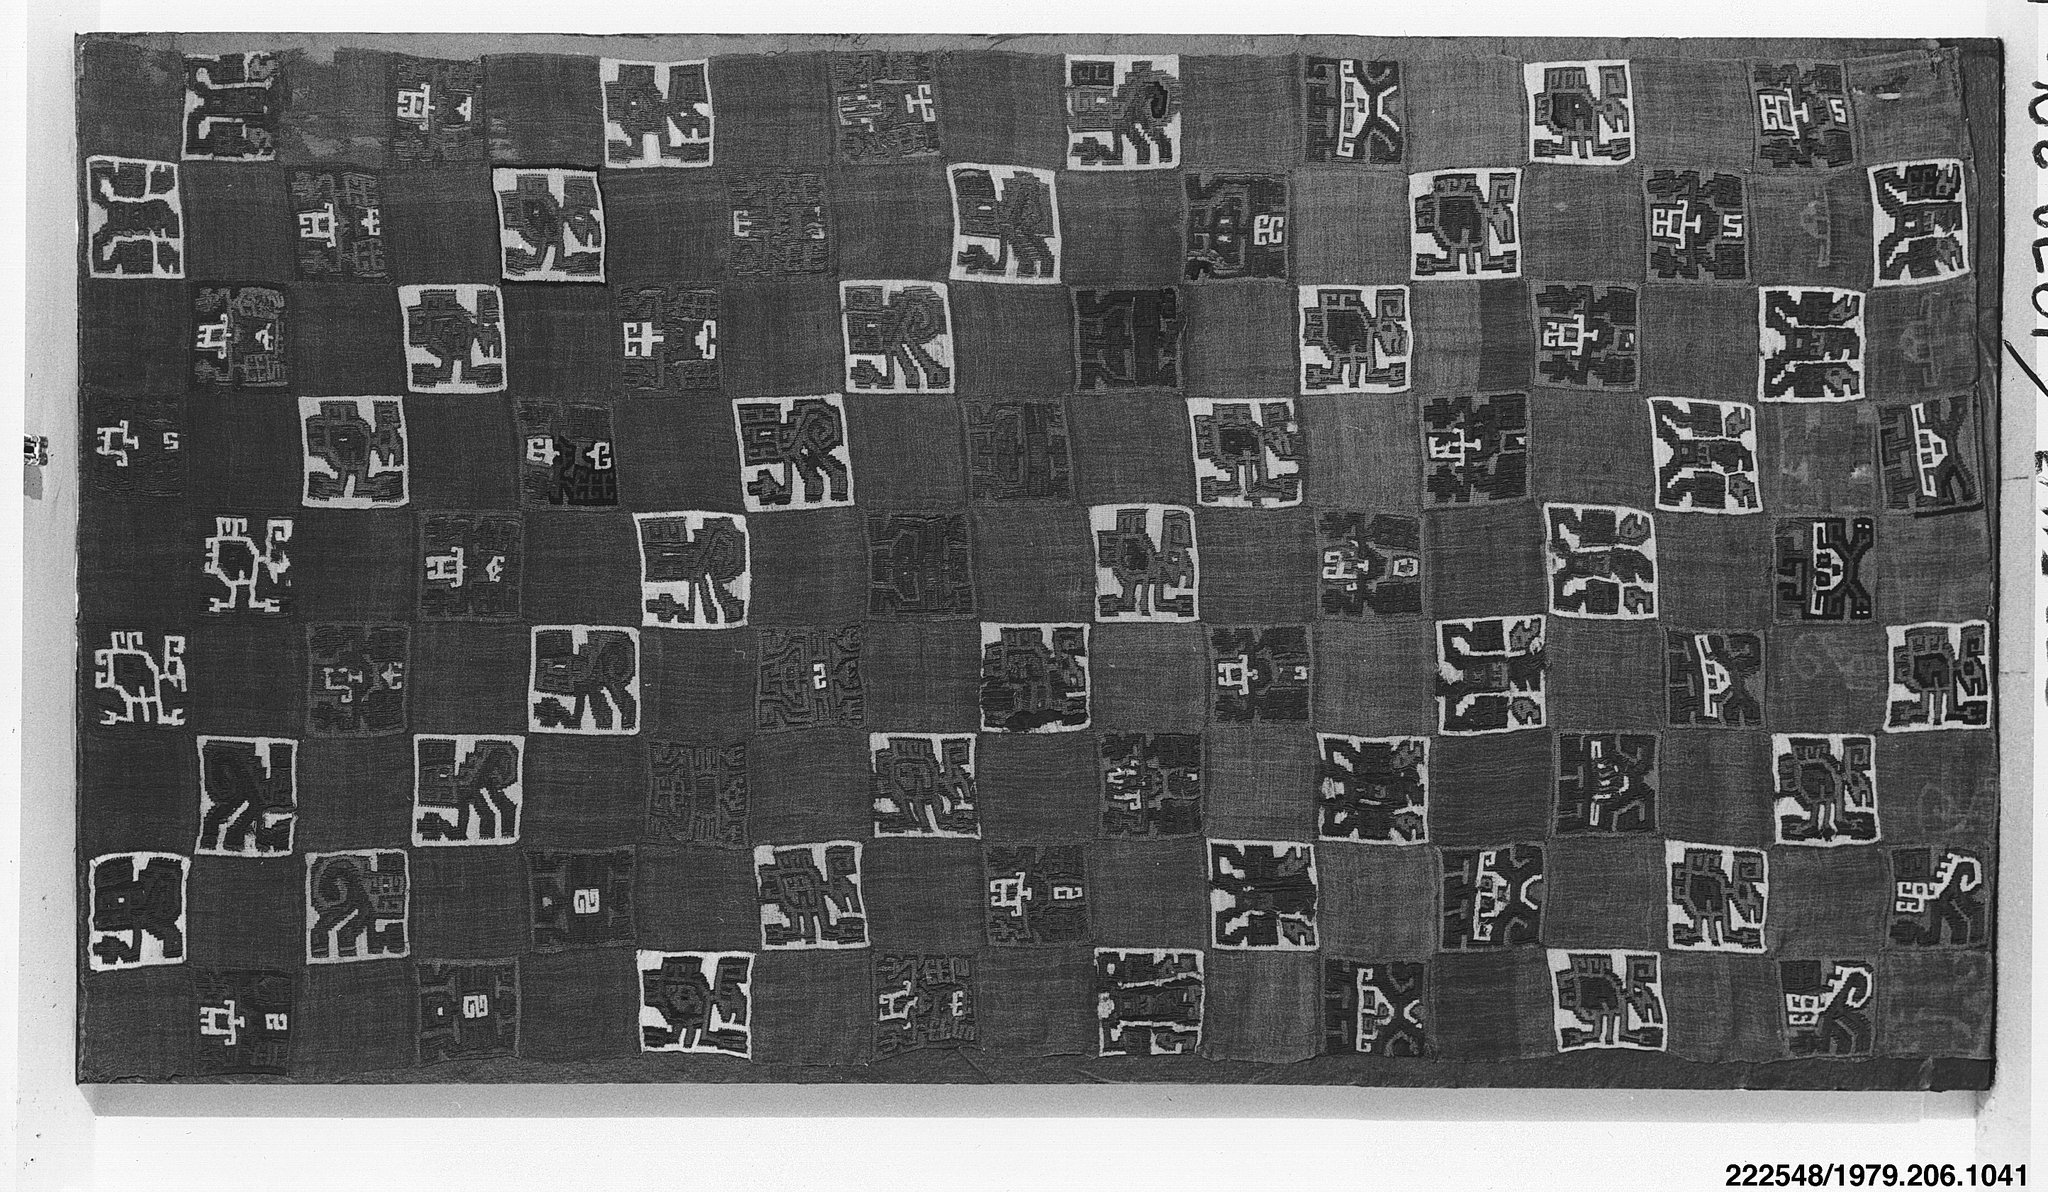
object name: hanging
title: Hanging (?)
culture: nasca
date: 601-700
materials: animal fiber, cotton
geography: peru